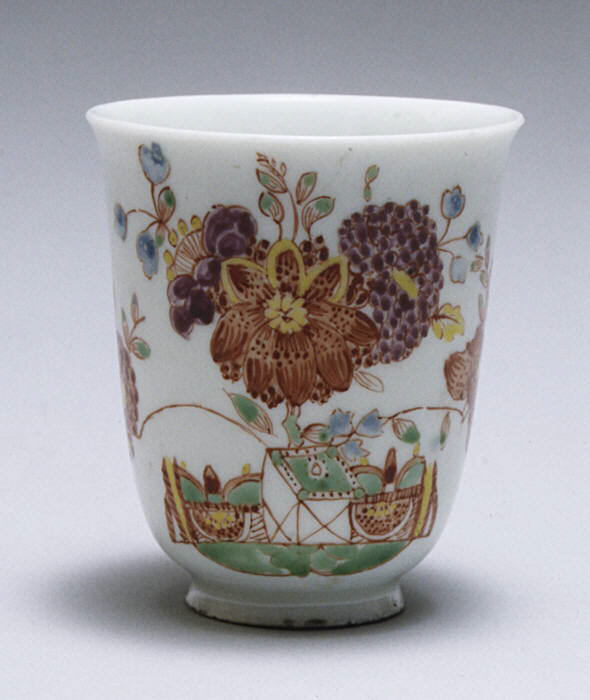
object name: beaker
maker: doccia porcelain manufactory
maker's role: manufactory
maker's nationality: italian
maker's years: 1737-1896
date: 1765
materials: hard paste porcelain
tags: flowers